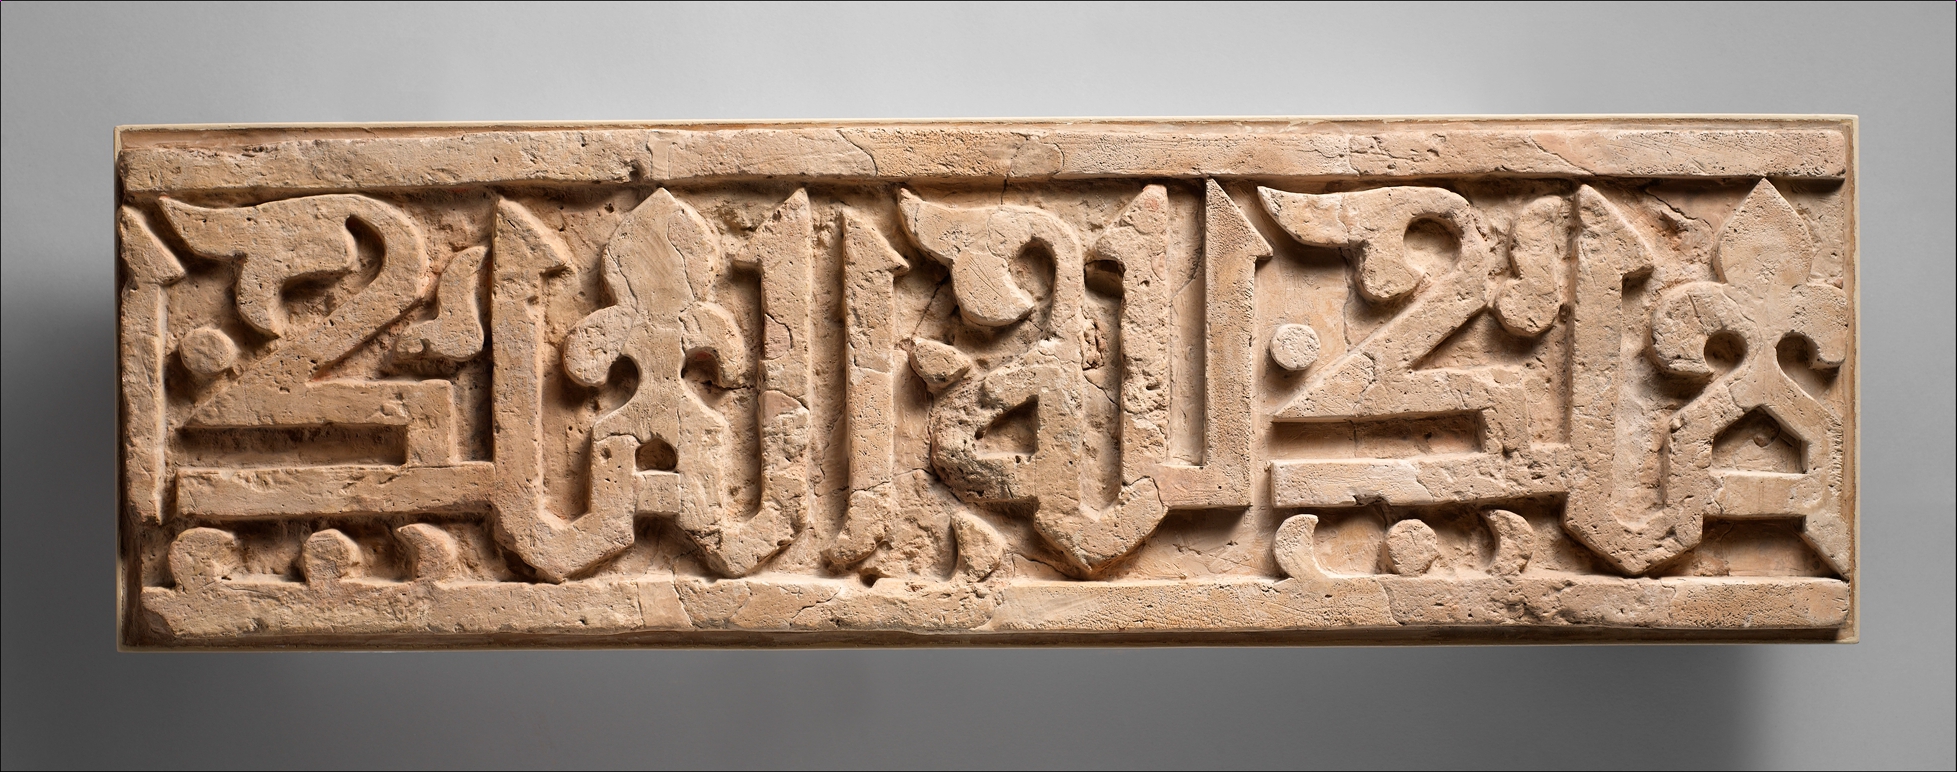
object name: frieze fragment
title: Fragment of a Frieze with Repeating Phrase, "Sovereignty is God's"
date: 1001-1100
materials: terracotta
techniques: carving, painting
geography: iran